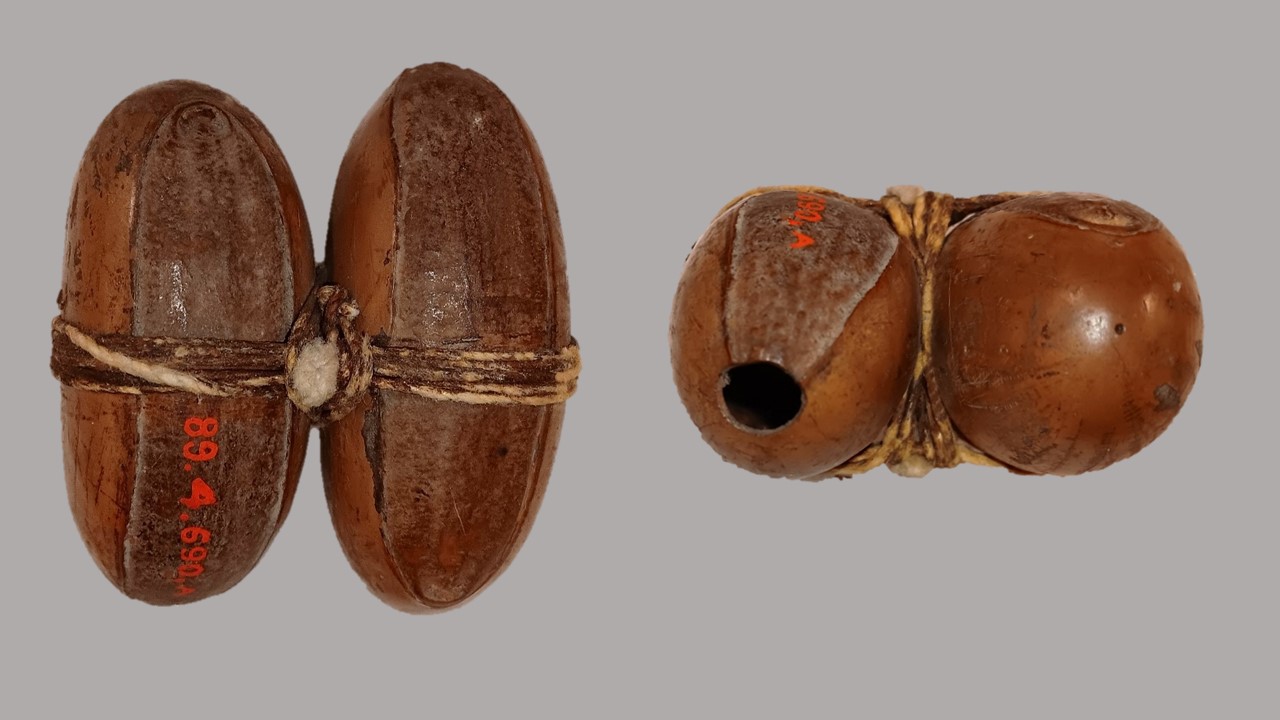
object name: humming nut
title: Humming nuts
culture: native american or guyanese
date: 1801-1900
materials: cord, shell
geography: guyana